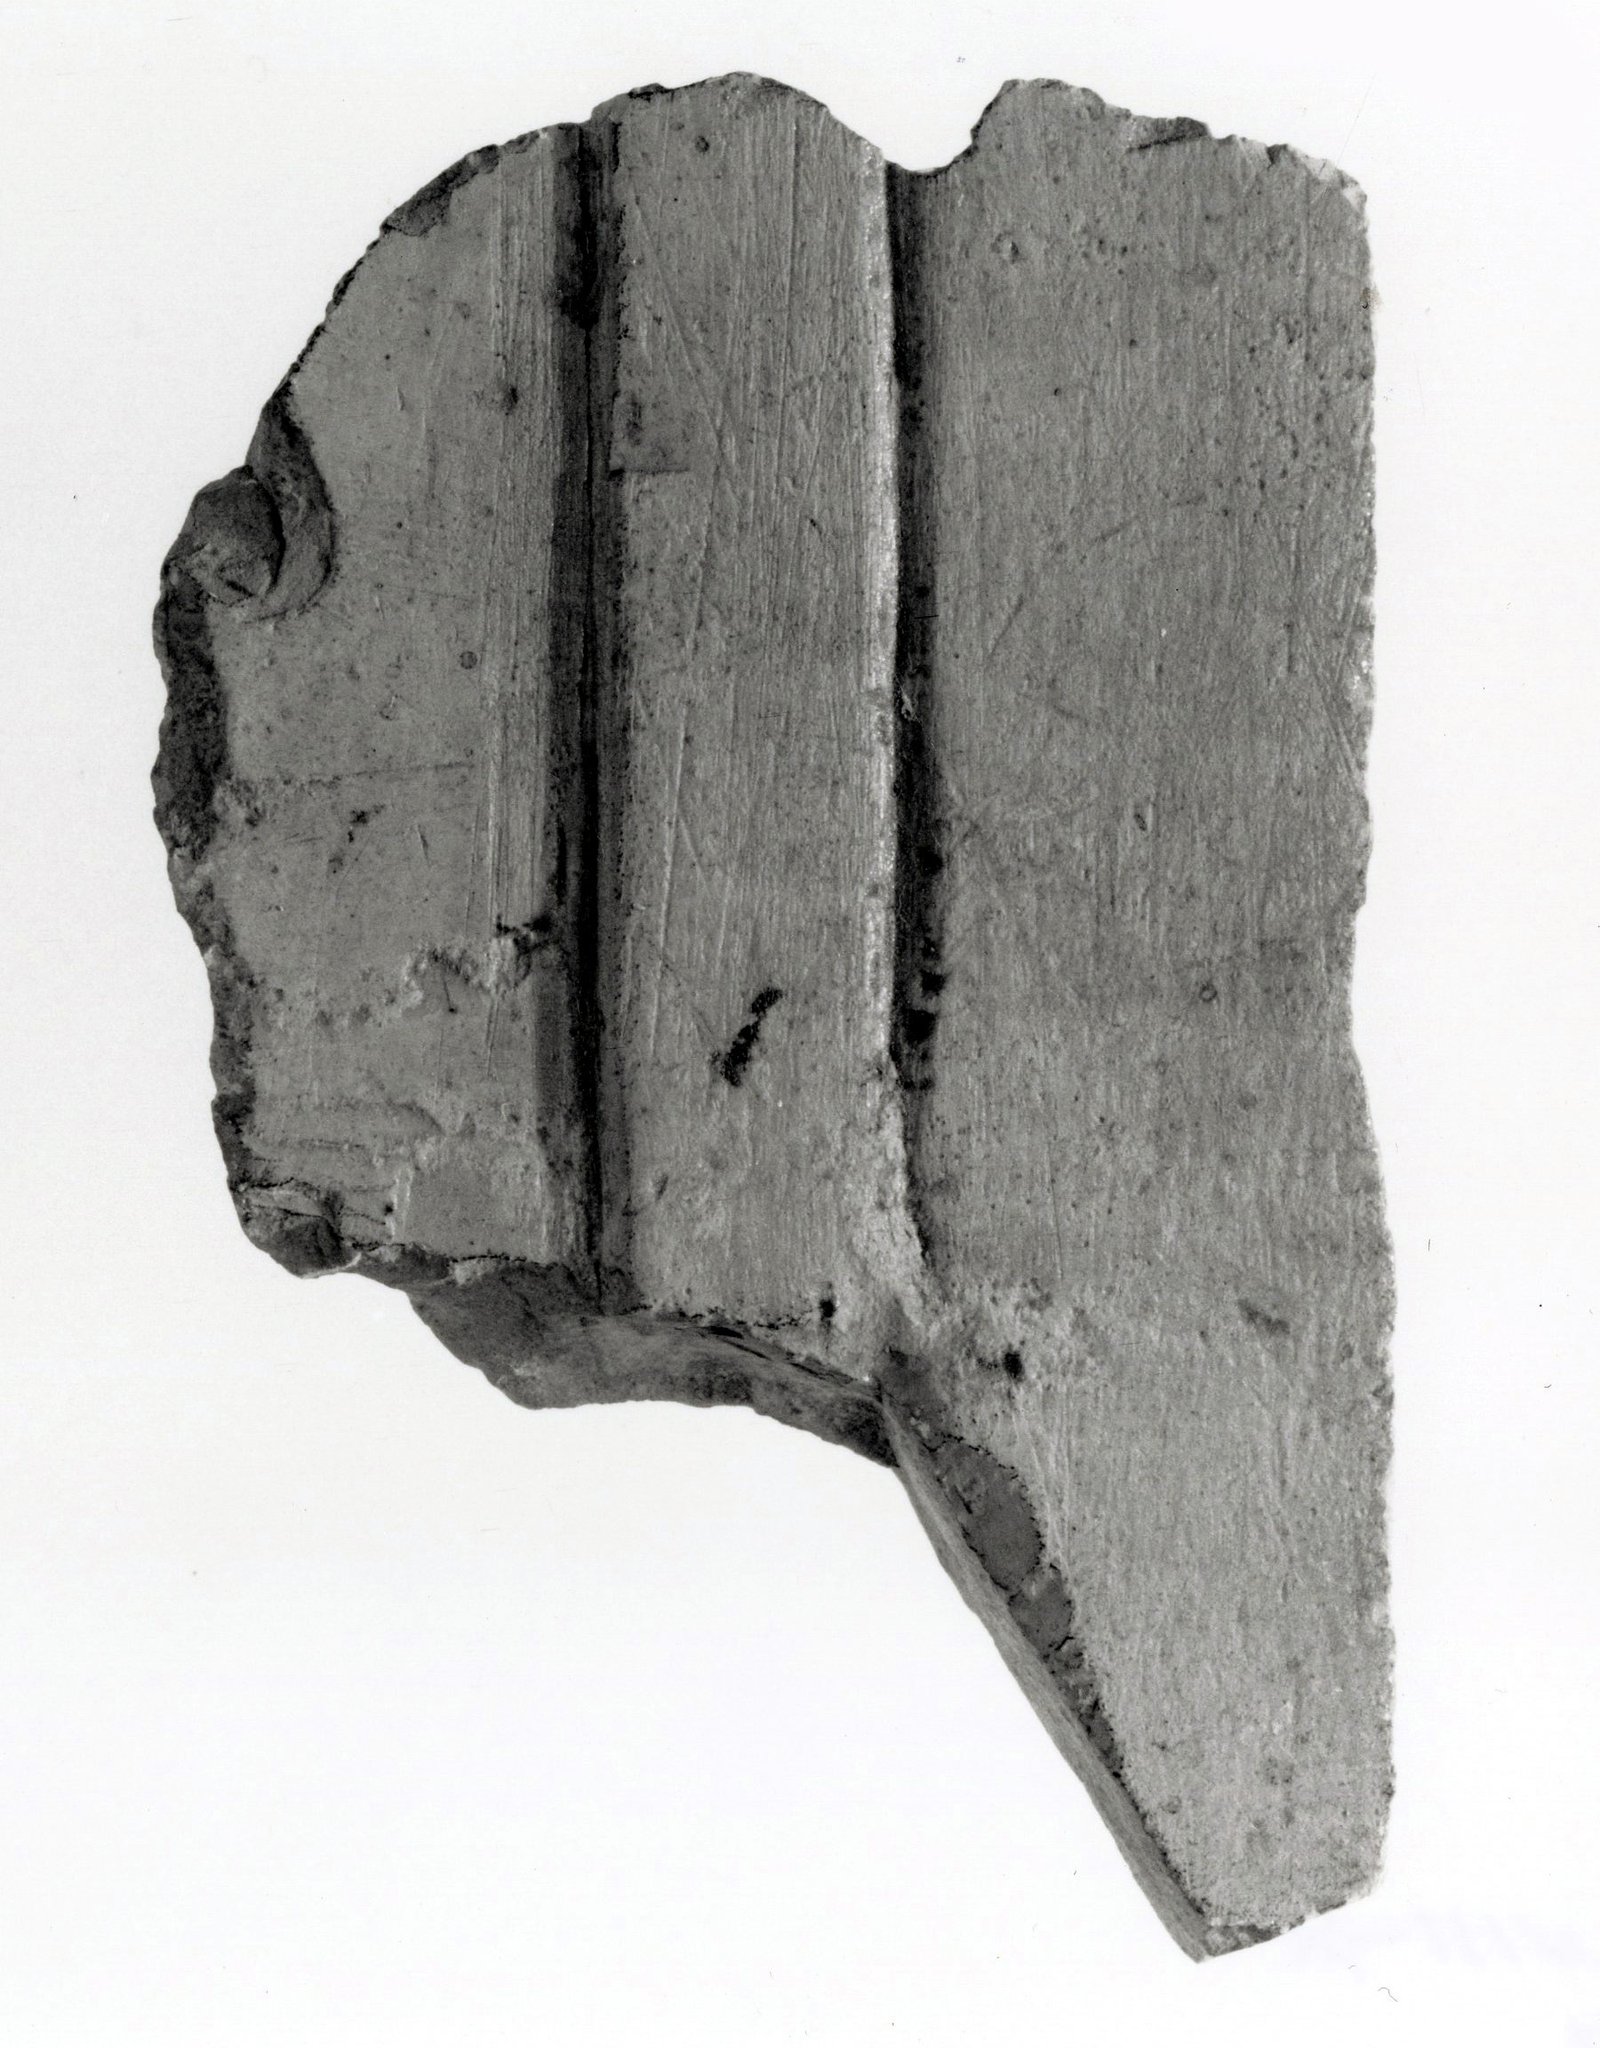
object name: relief, tomb of nespekashuty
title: Raised relief fragment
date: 664-610 BCE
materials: limestone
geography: egypt